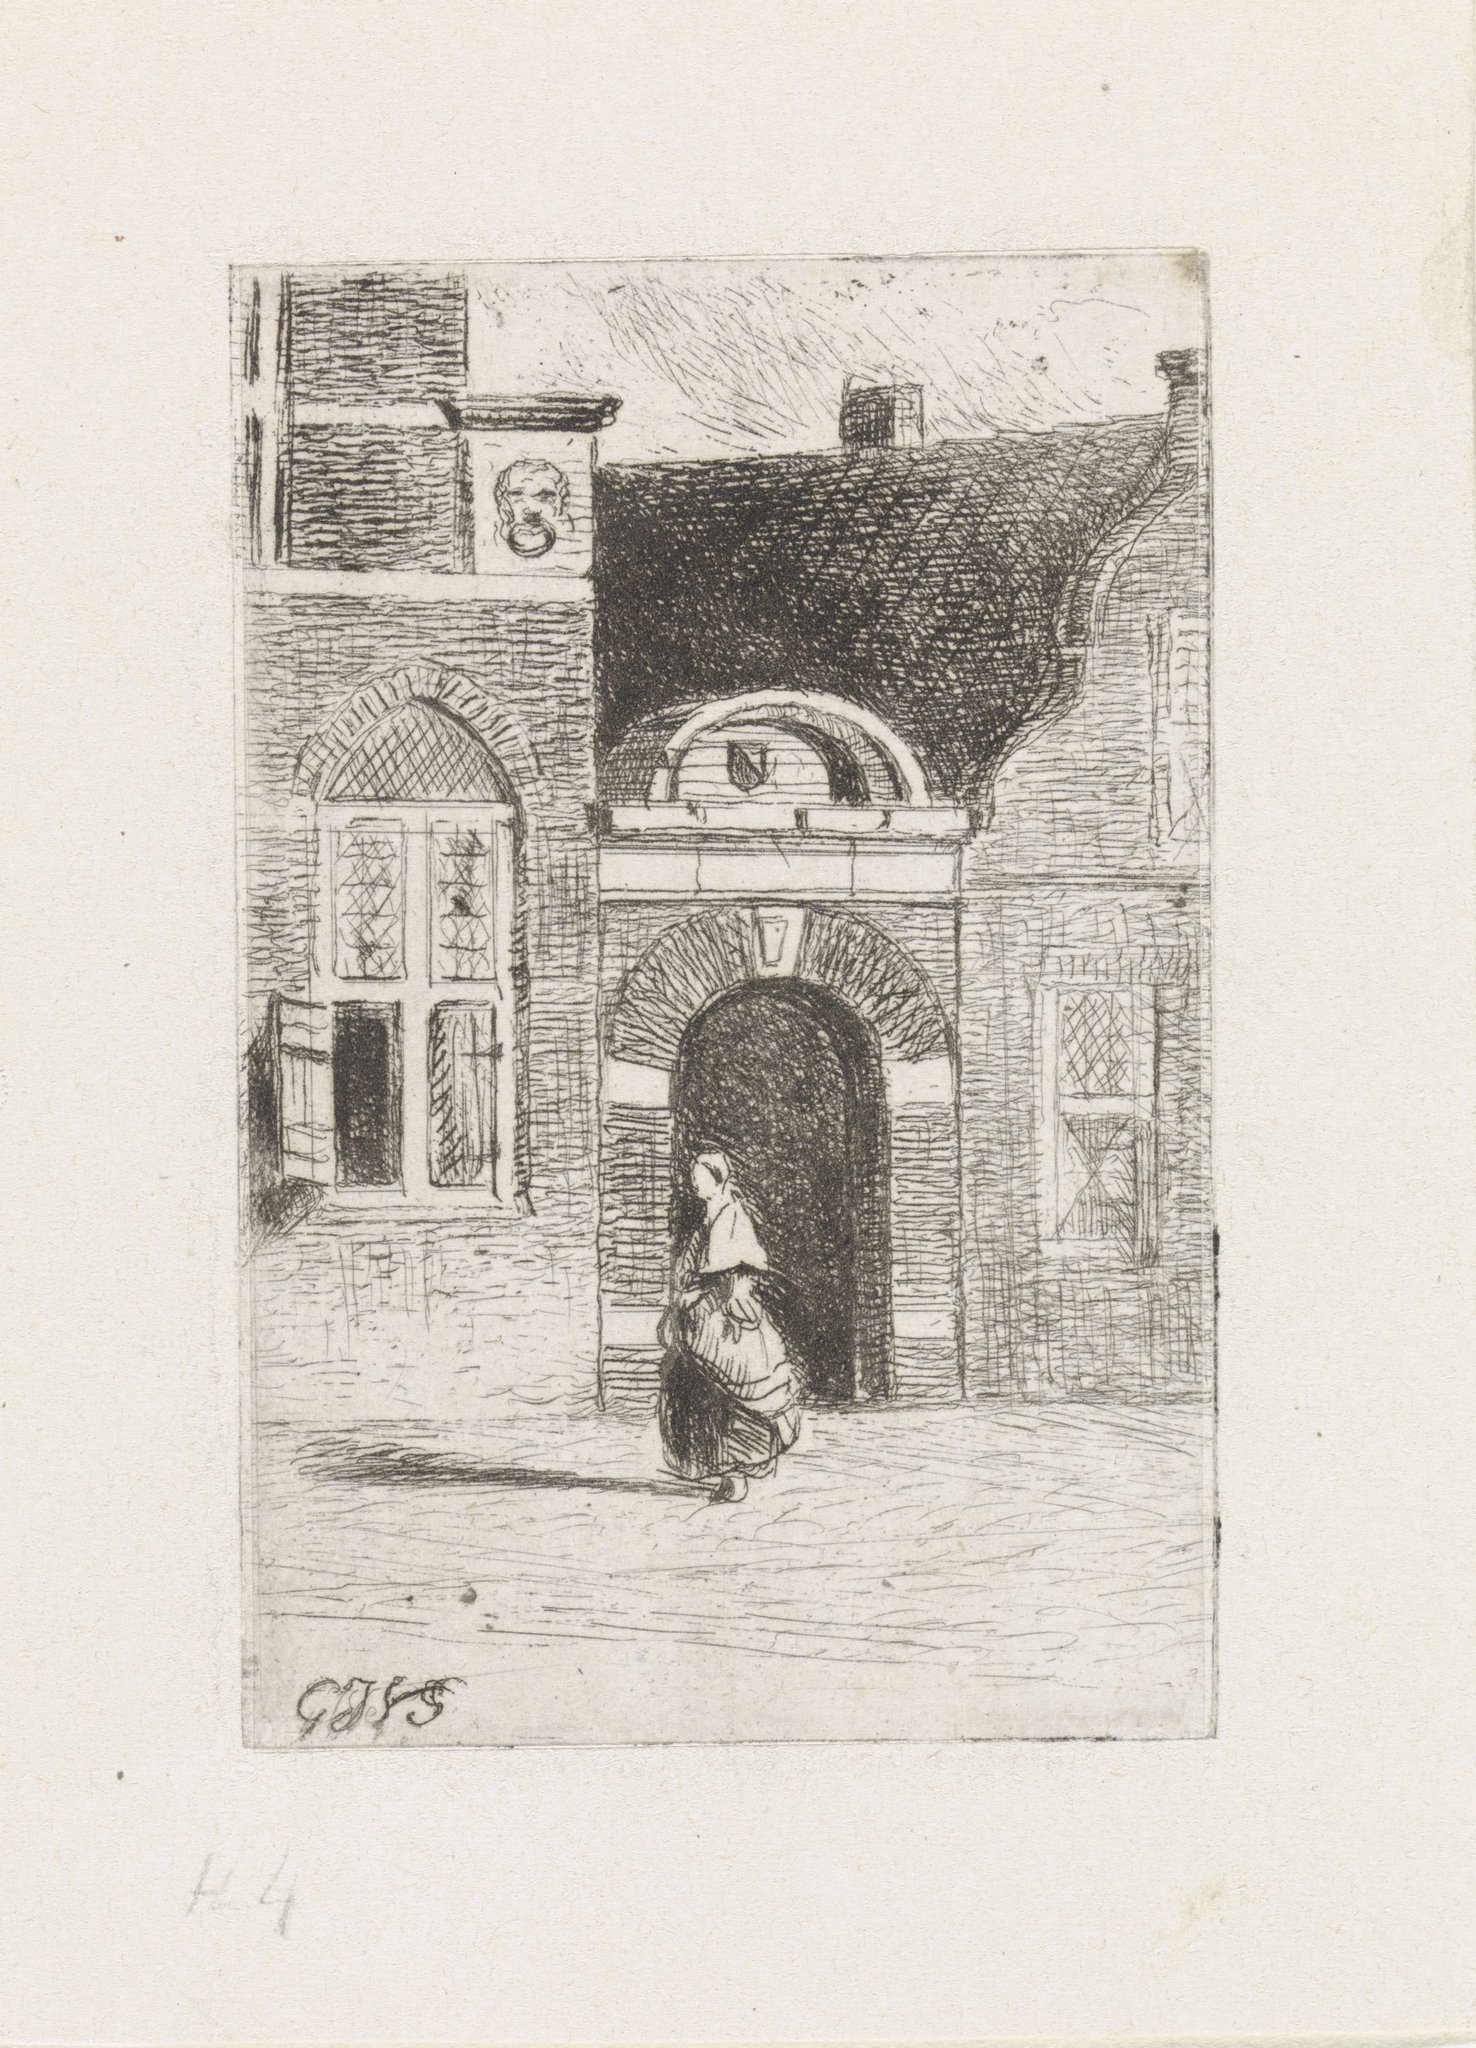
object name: print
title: Bakstenen poort in een straat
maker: gijsbertus johannes verspuy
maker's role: print maker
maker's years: 1823-1862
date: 1833-1862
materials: paper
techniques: etching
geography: netherlands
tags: gate, entrance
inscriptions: collector's mark: Lugt 2228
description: Gezicht op een bakstenen poort tussen huizen. Op straat loopt een vouwenfiguur.